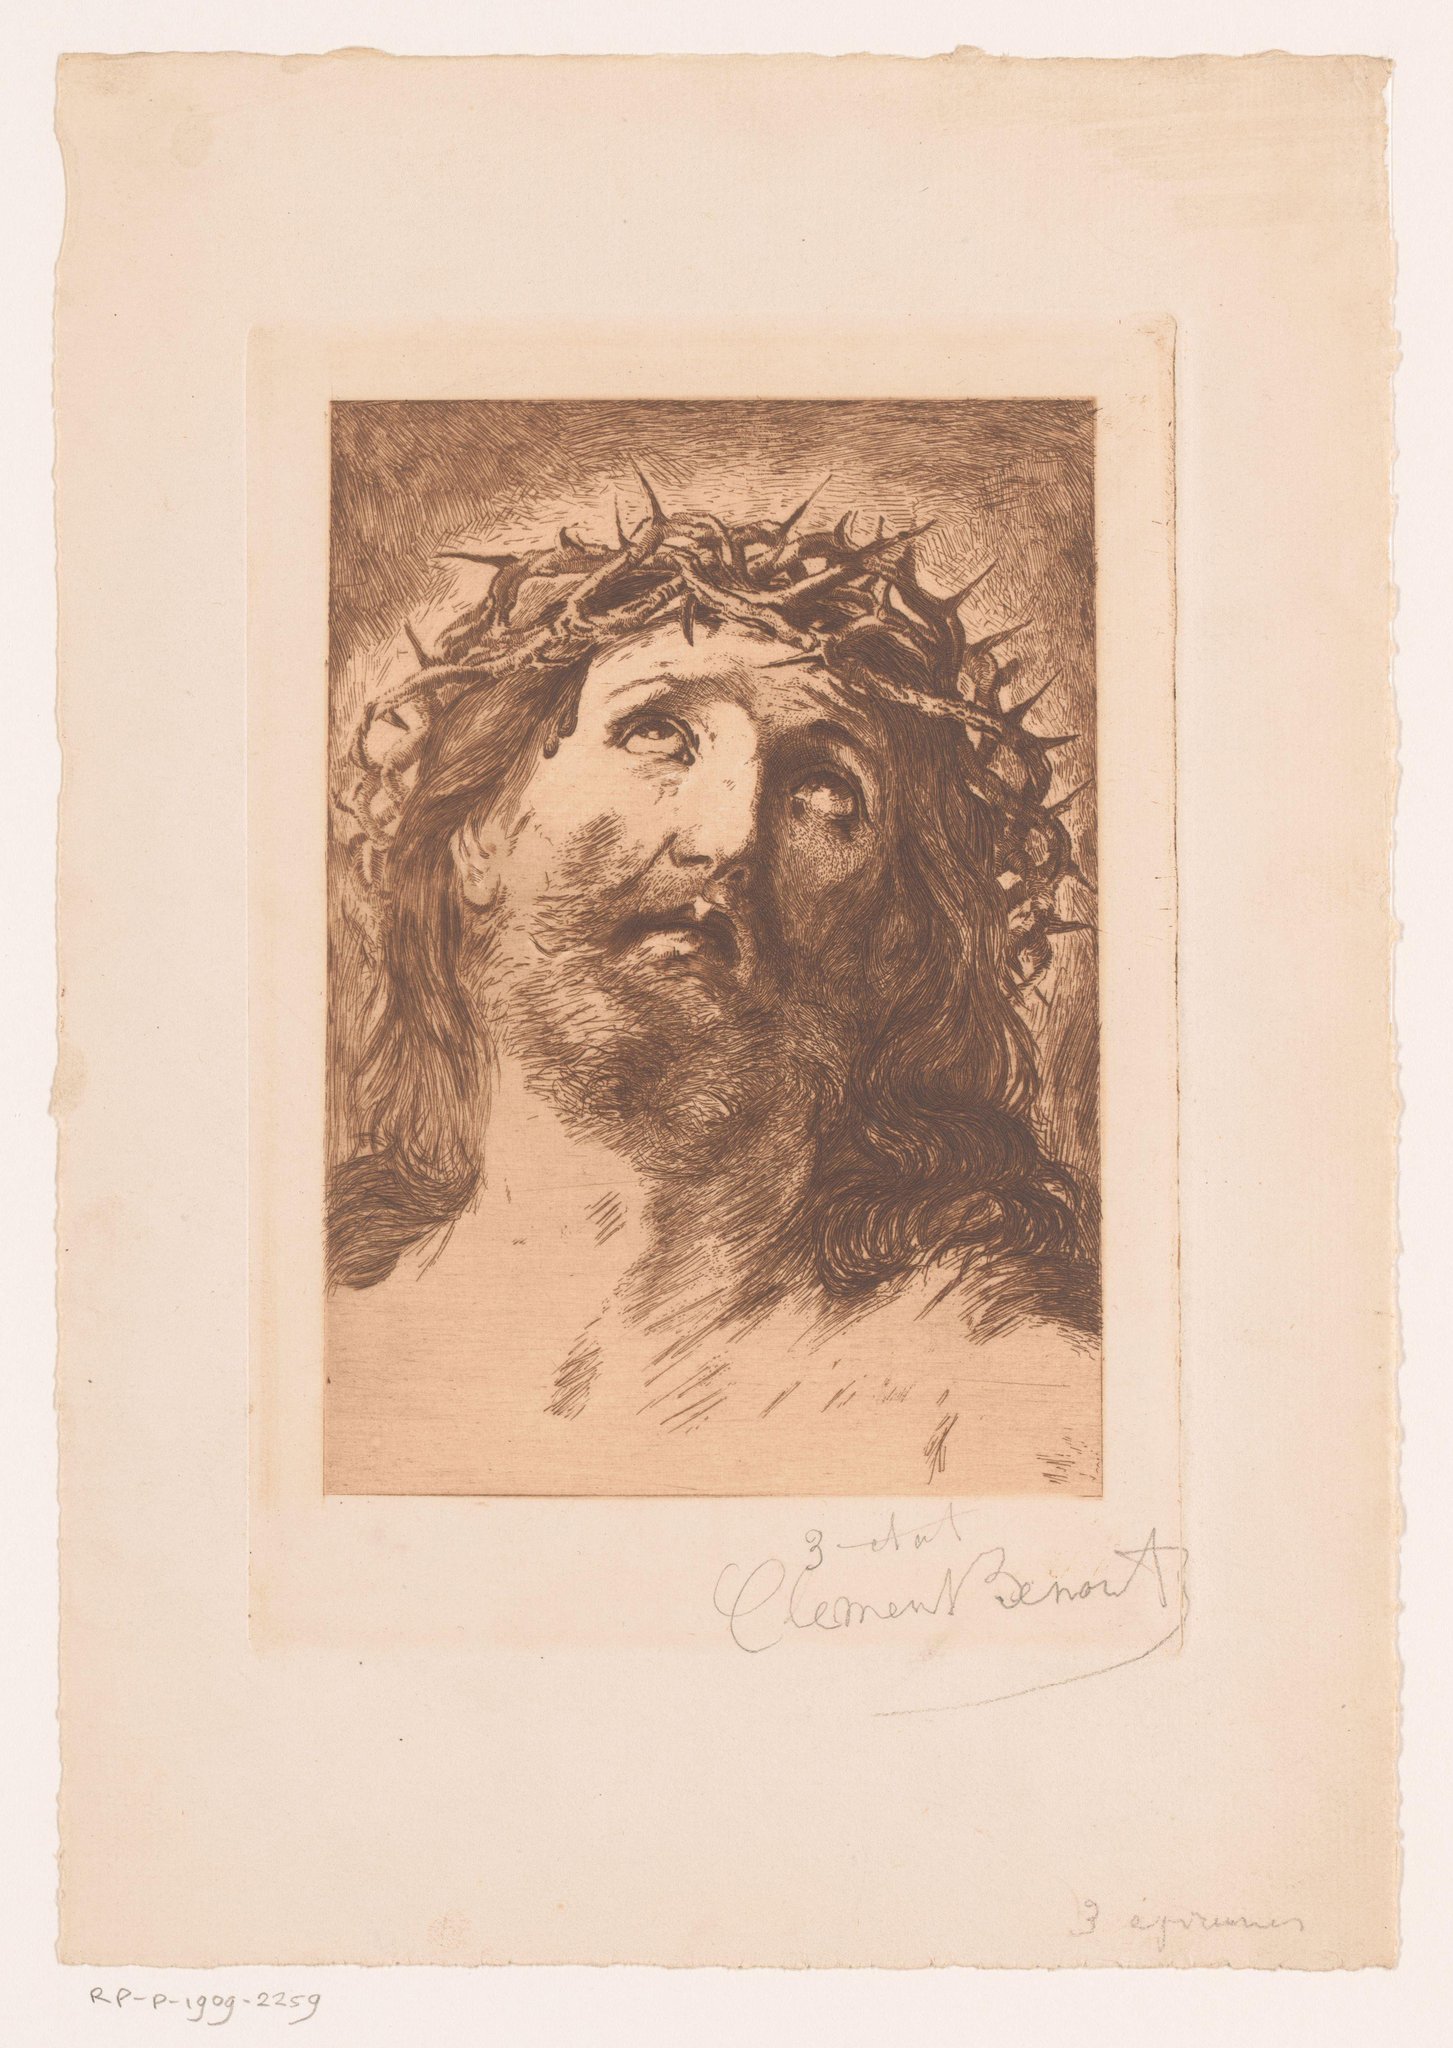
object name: print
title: Christus met doornenkroon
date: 1876-1909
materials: paper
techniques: etching, intaglio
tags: head of christ with crown of thorns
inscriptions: inscription: ‘5 une tete de christ par Benoit’, collector's mark: Lugt 2228